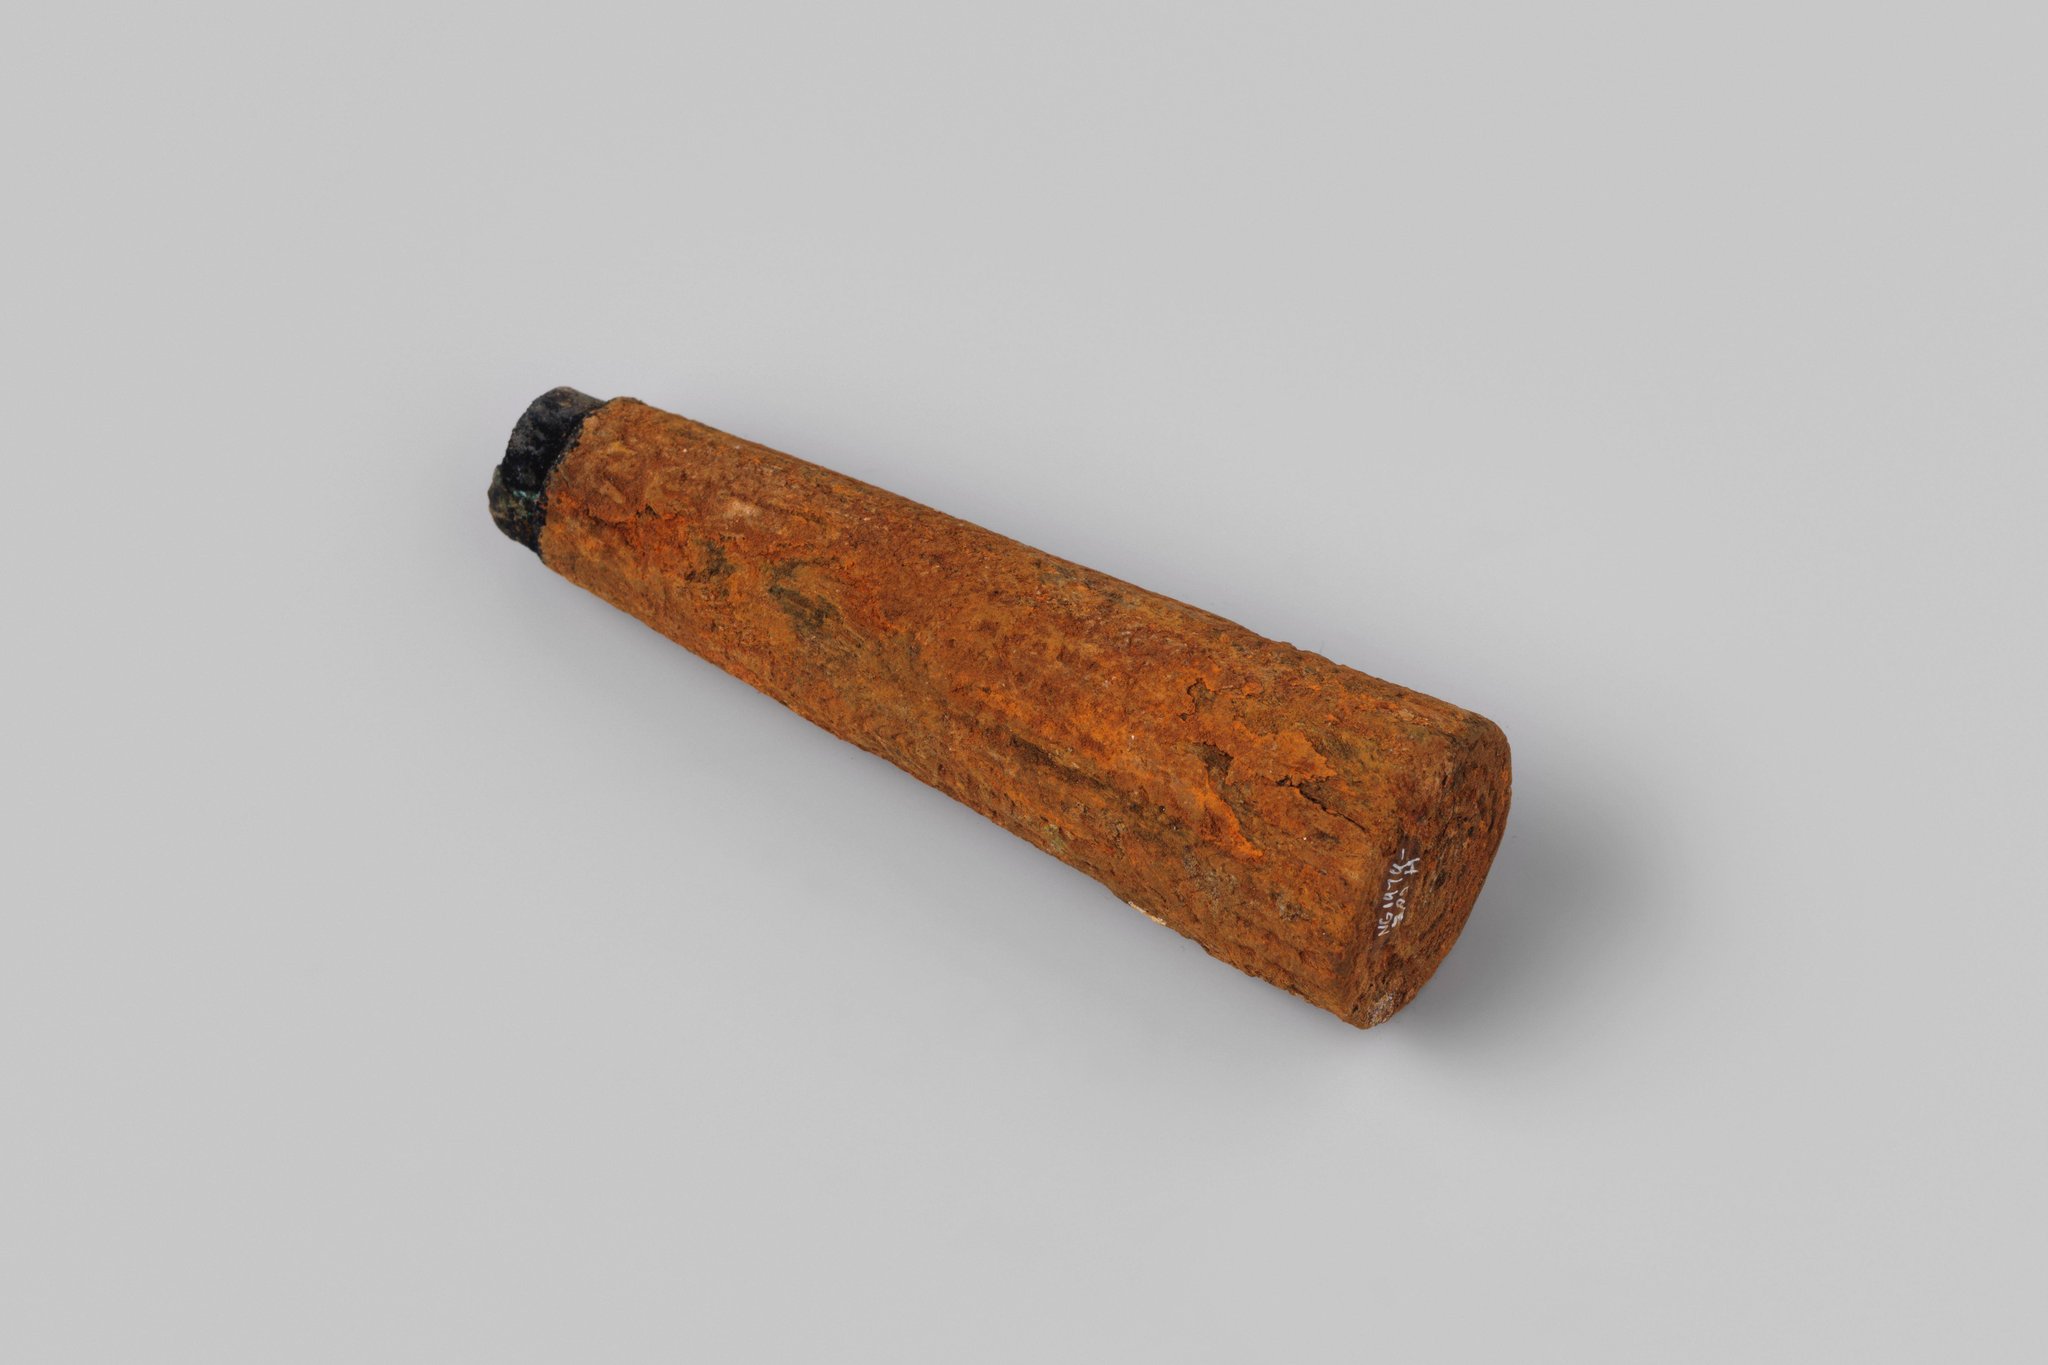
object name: knife handle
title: Messenheft uit het wrak van de Oost-Indiëvaarder Hollandia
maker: Anonymous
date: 1700-1743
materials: copper, wood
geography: netherlands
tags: verenigde oostindische compagnie, hollandia (schip), annet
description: Knife, handle, cylindrical: tapering; id. NG 1979-403H, ferrules id. NG 1980-27H426.